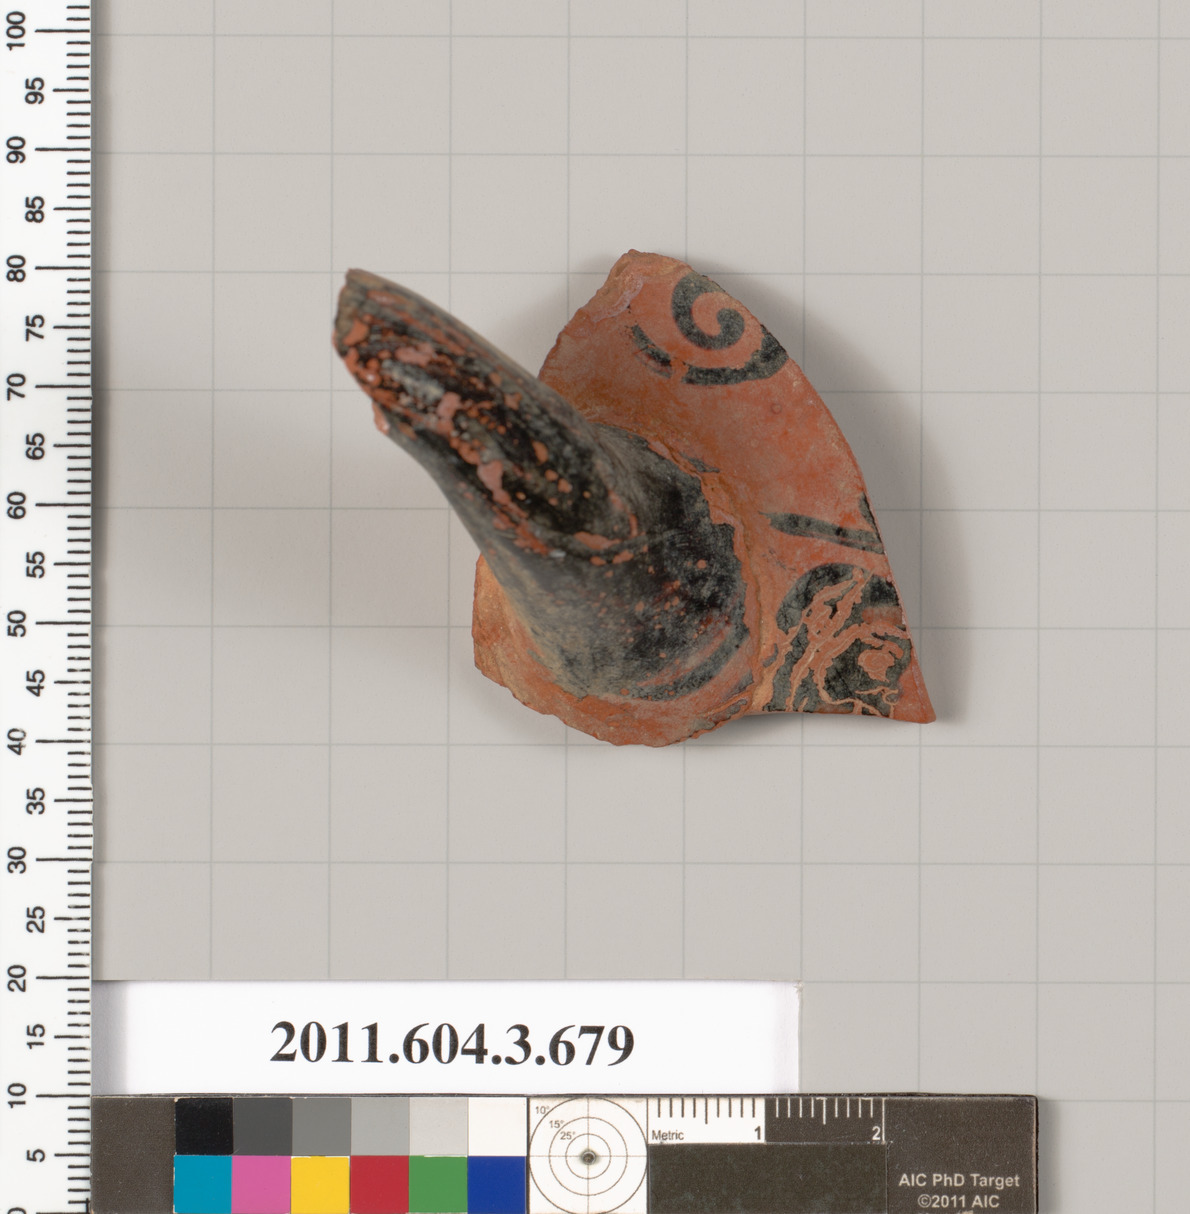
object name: stamnos fragment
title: Terracotta fragment of a stamnos (jar)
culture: greek, attic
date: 510-500 BCE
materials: terracotta